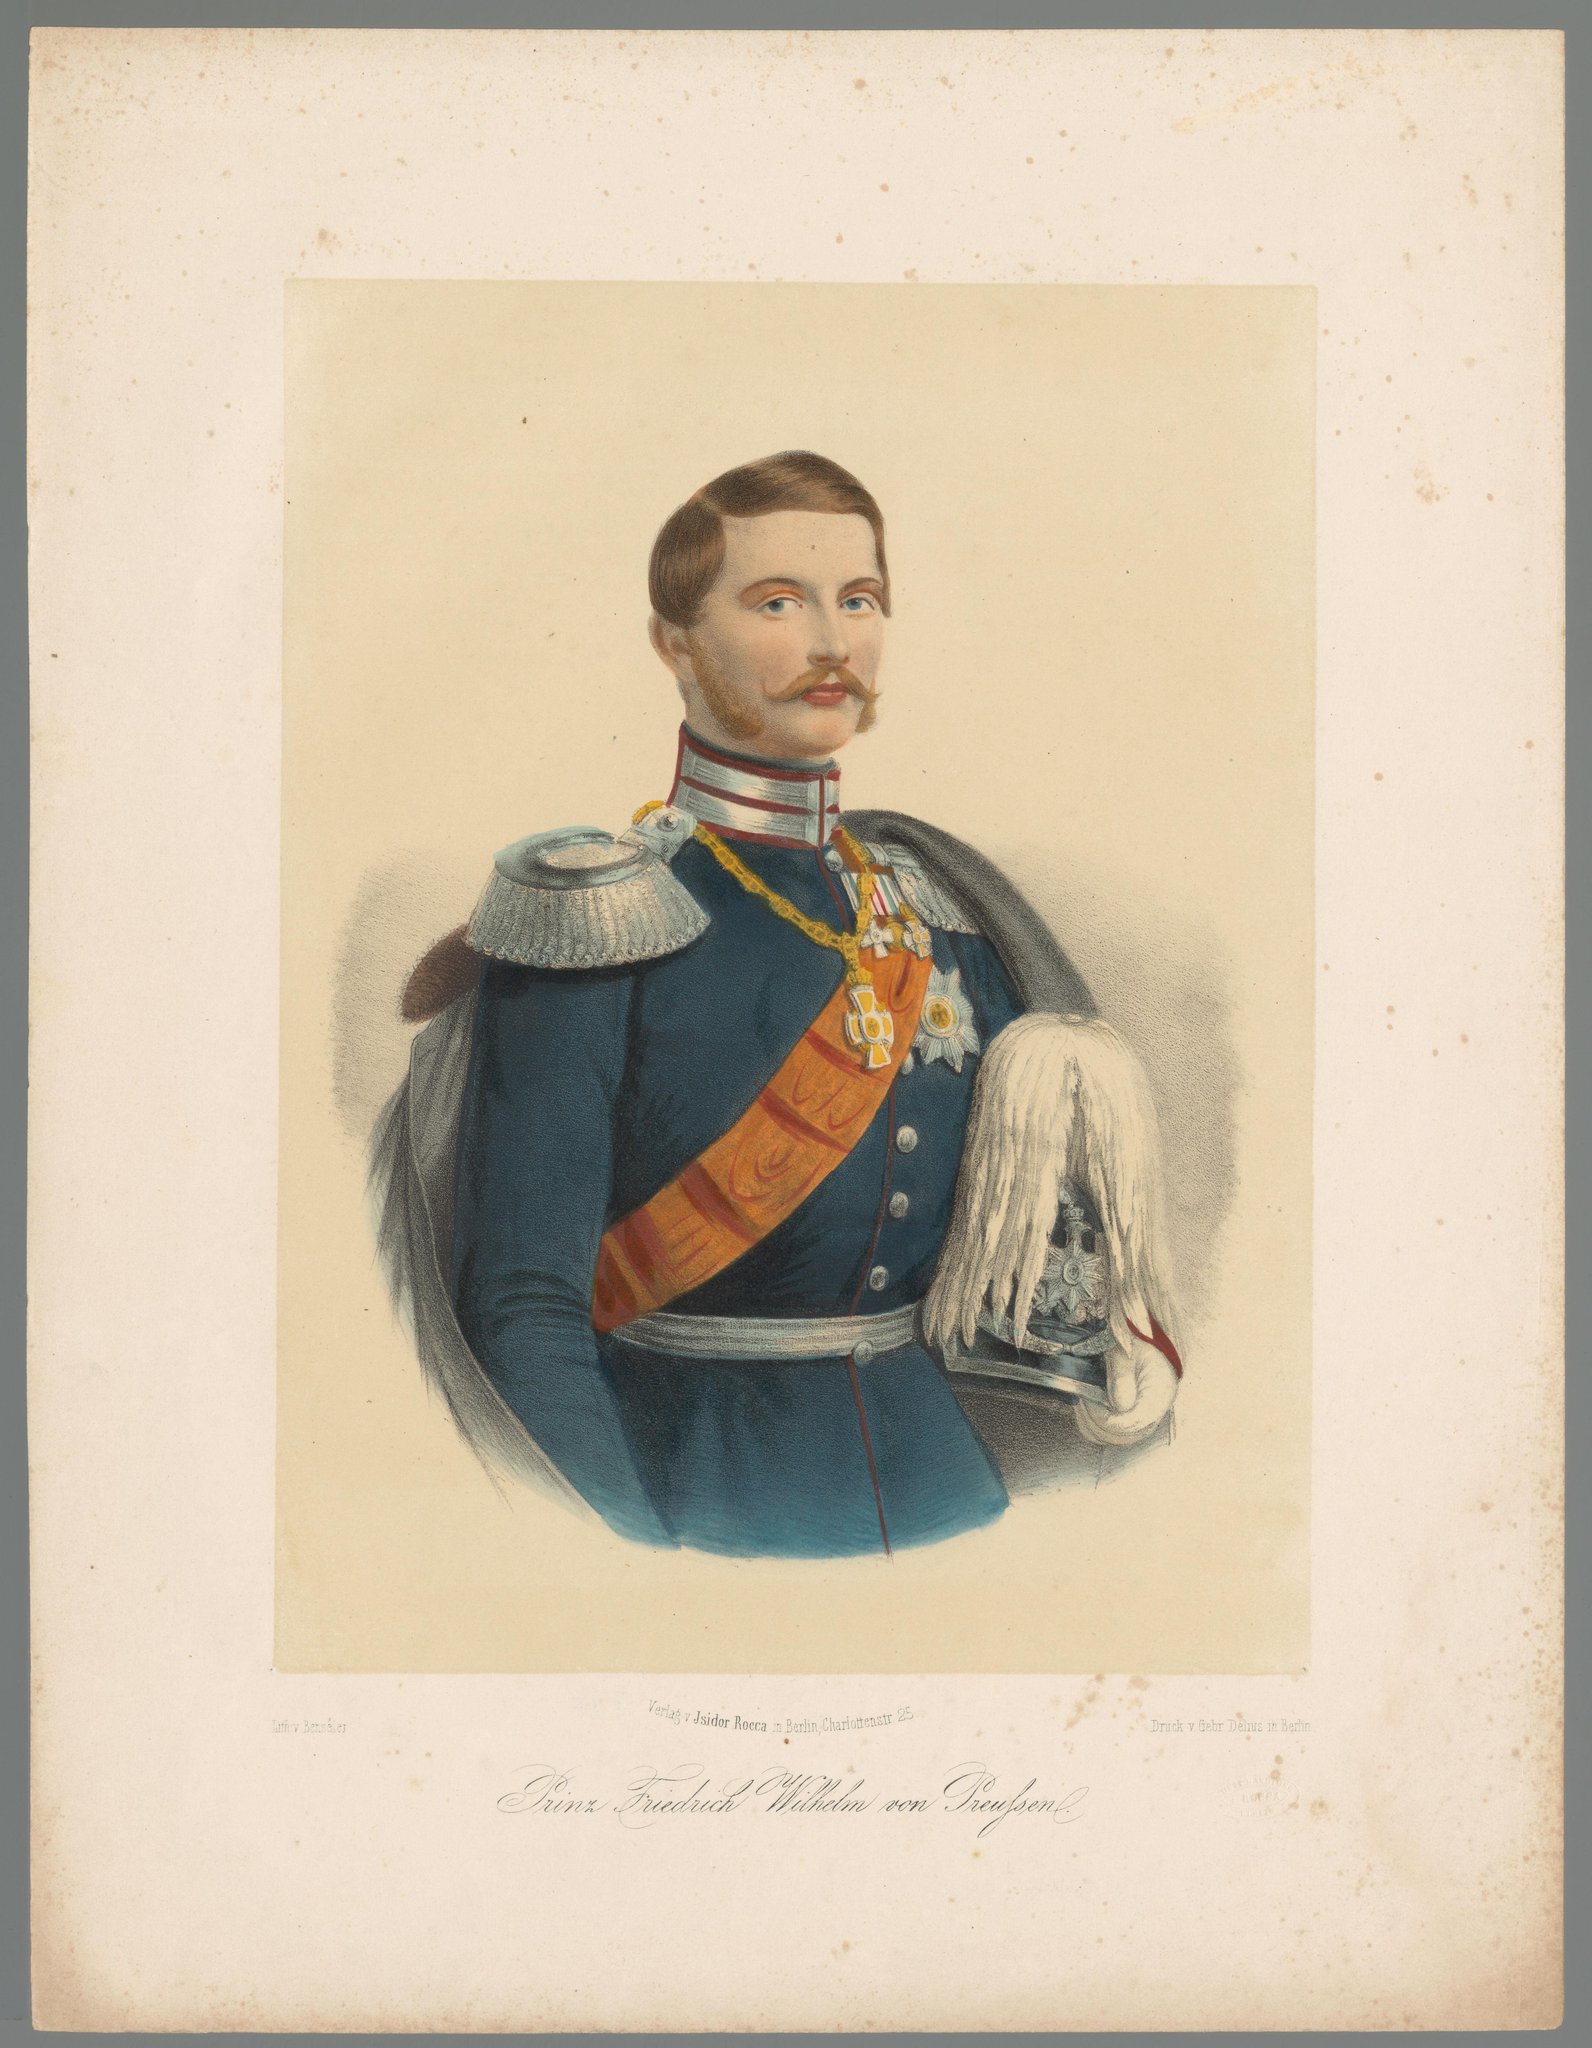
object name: print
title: Portret van Frederik III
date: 1850-1899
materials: paper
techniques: hand coloring, lithograph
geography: berlin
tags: moustache, adult man, historical persons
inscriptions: collector's mark: Lugt 2228, check stamp: ‘Kunsthandlung I. Rocca Berlin’